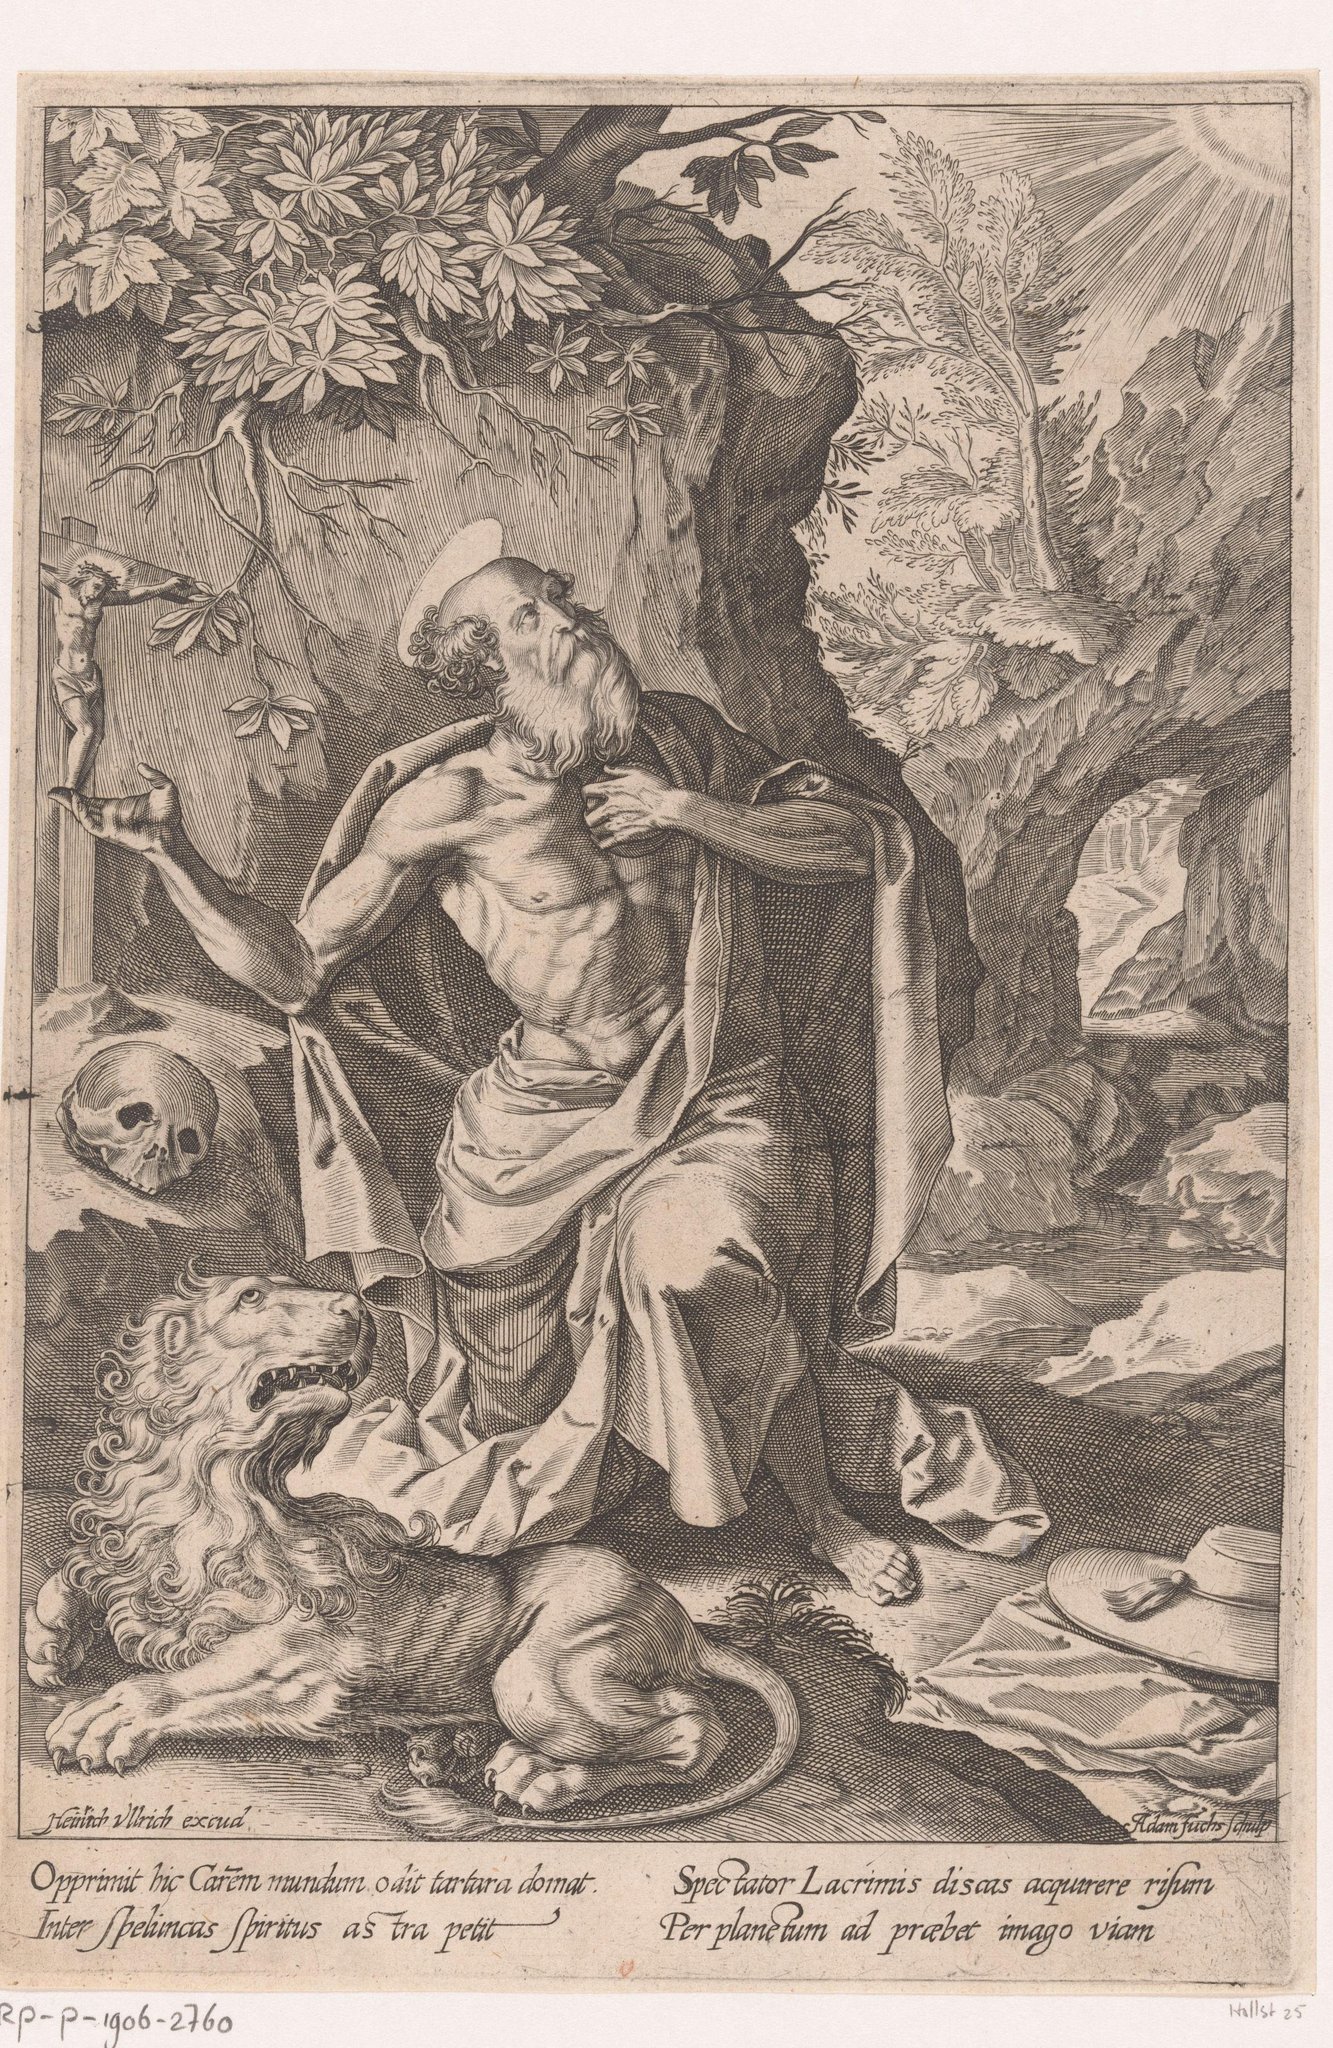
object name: print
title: Heilige Hieronymus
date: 1550-1606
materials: paper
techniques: engraving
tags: the monk and hermit jerome (hieronymus); possible attributes: book, cardinal's hat, crucifix, hour-glass, lion, skull, stone, meditation over skull and/or crucifix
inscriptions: collector's mark: Lugt 2228